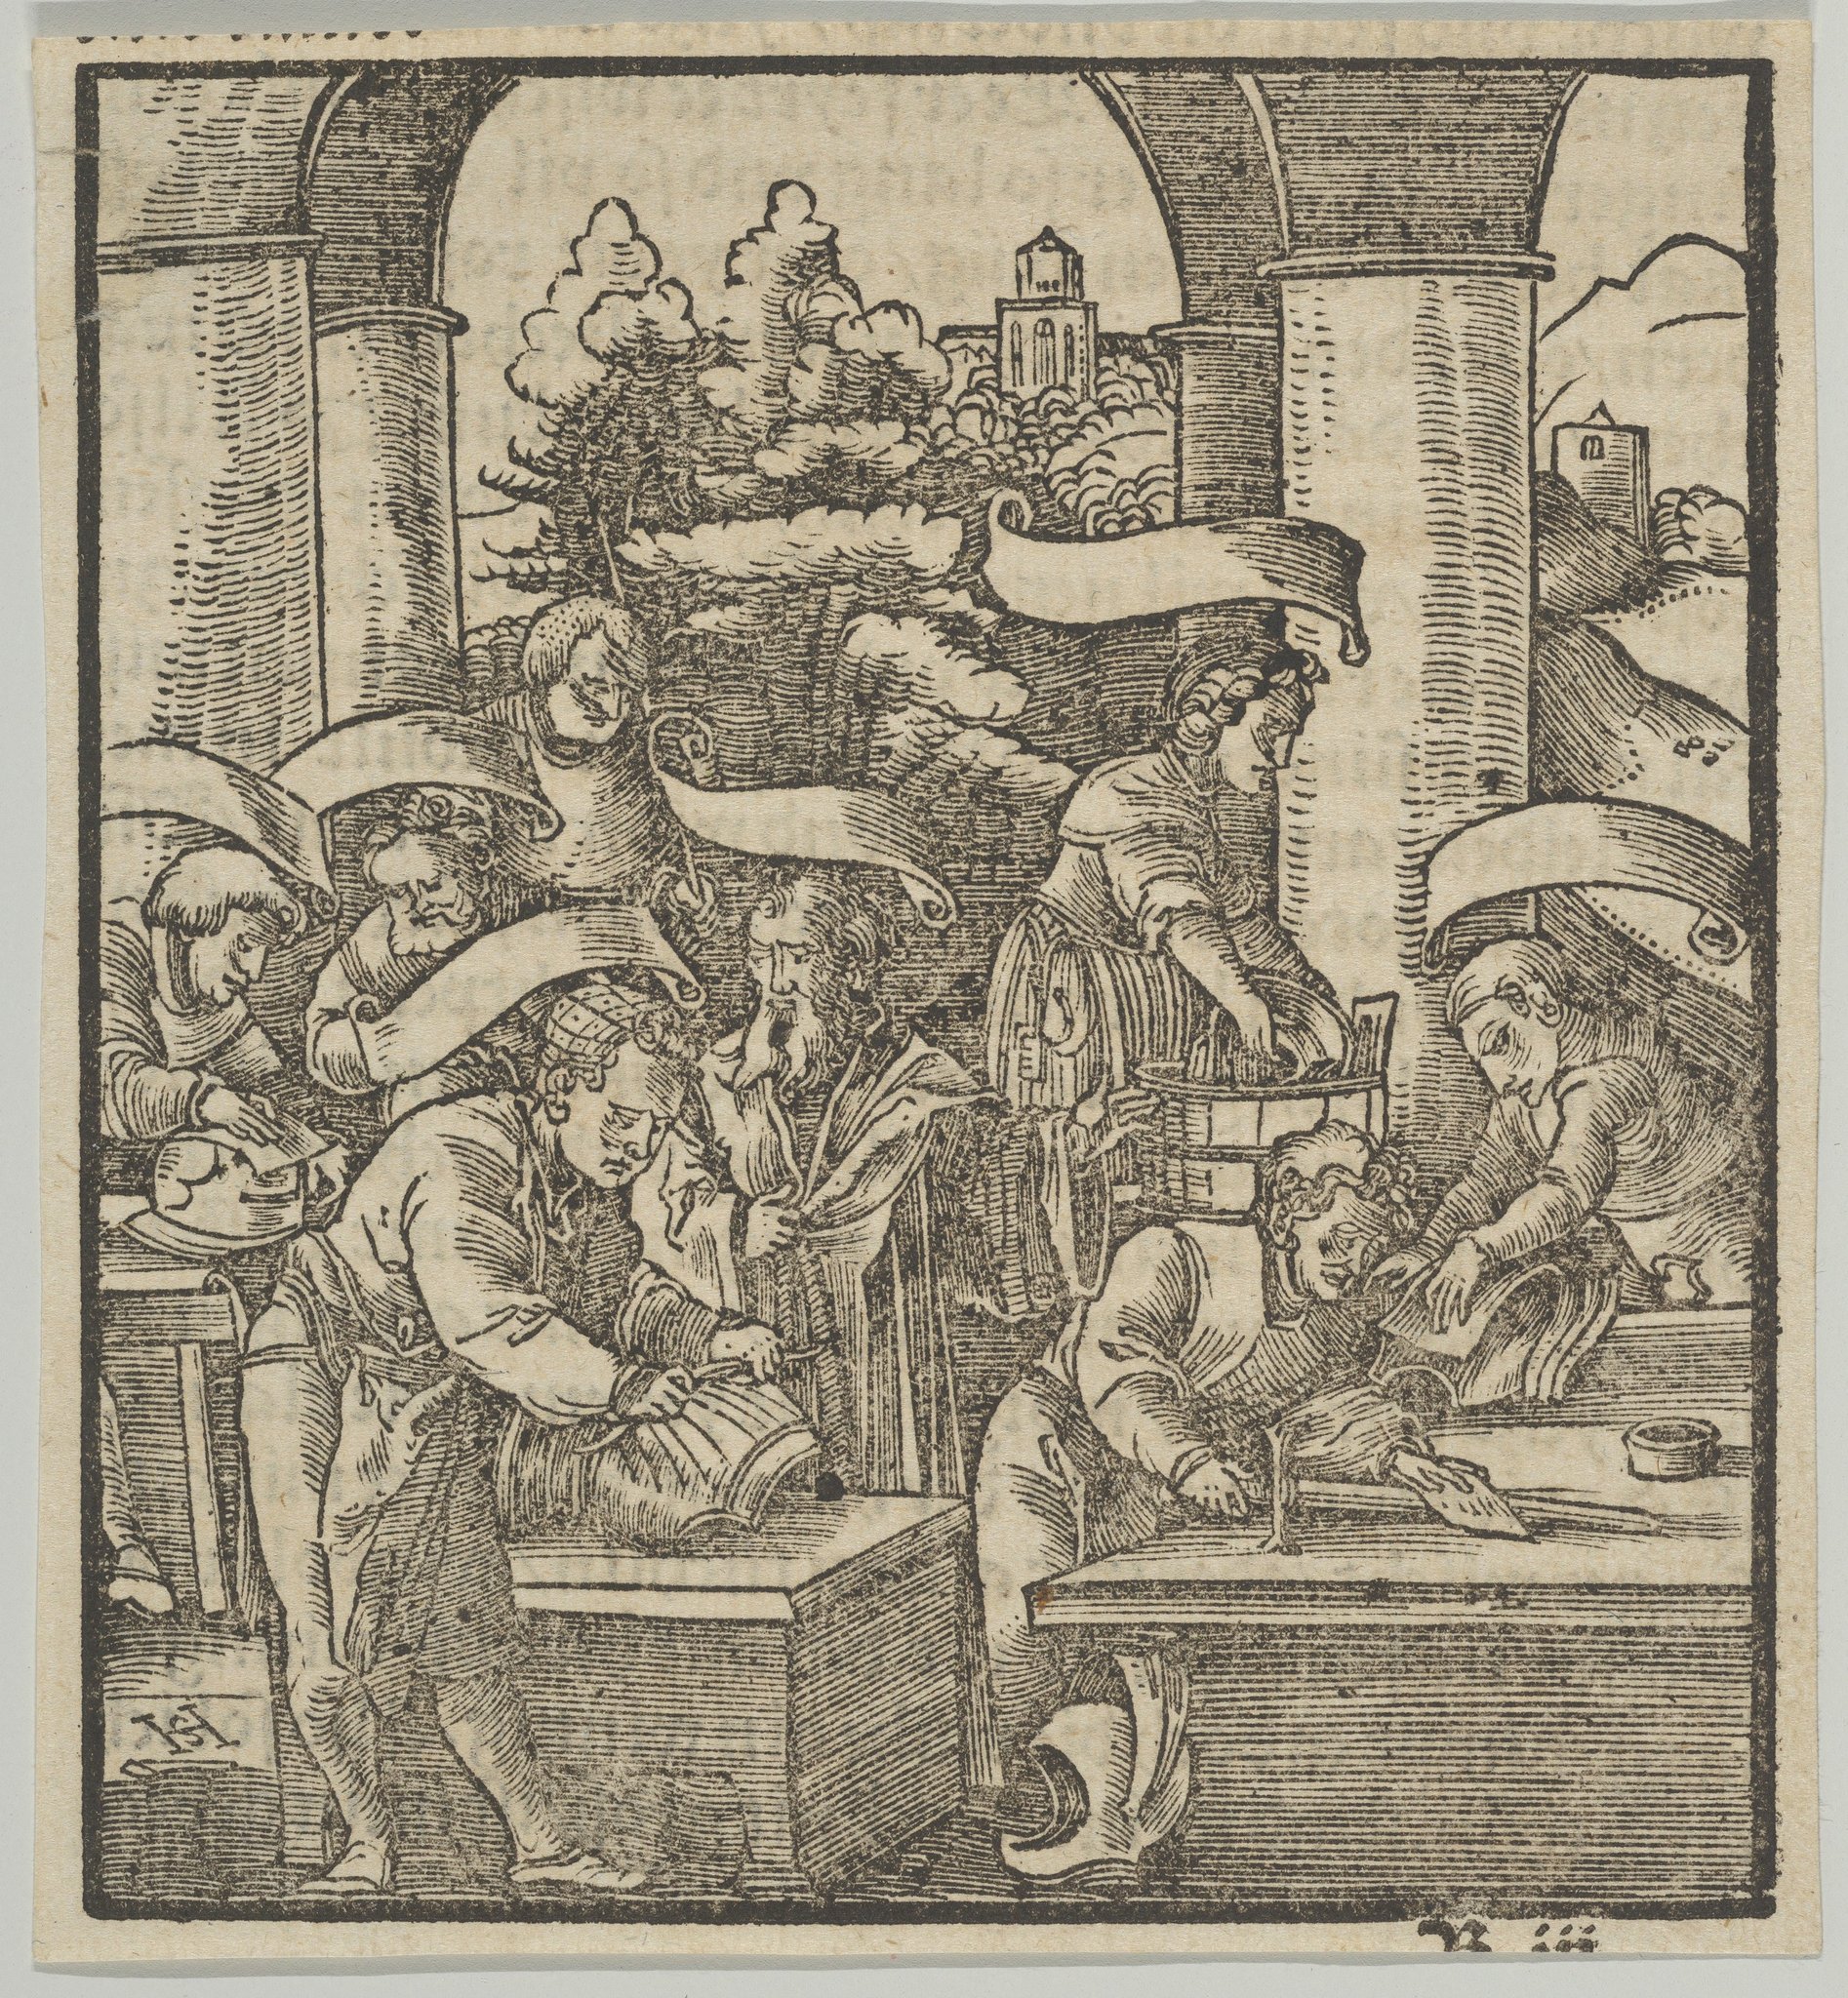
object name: print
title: The Making of Armours, from Hymmelwagen auff dem, wer wol lebt...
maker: hans schäufelein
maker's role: artist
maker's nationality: german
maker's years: 1480-1540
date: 1517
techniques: woodcut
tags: armor,men,women,working